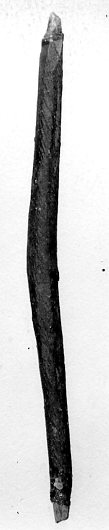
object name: model, bed, frame fragment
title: Fragment of the Frame of a Model Bed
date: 1550-1295 BCE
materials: wood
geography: egypt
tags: furniture